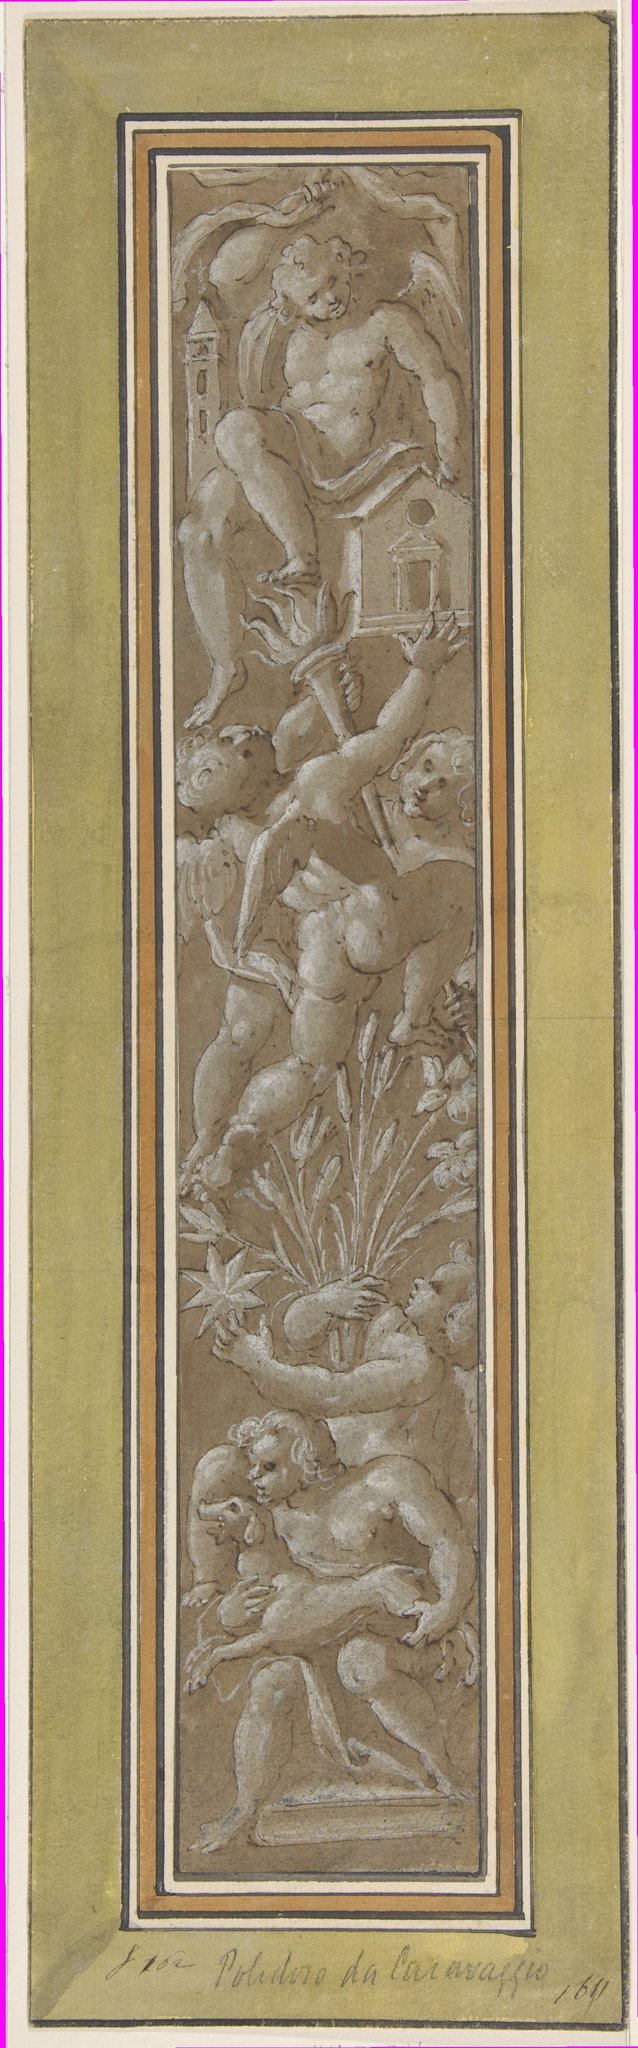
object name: drawing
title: Two Pilaster with White Putti on Tan Ground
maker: giovanni mauro della rovere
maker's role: artist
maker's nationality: italian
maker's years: 1575-1640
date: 1575-1640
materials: chalk, ink, paper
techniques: brush, highlighting, pen, wash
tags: putti,dogs